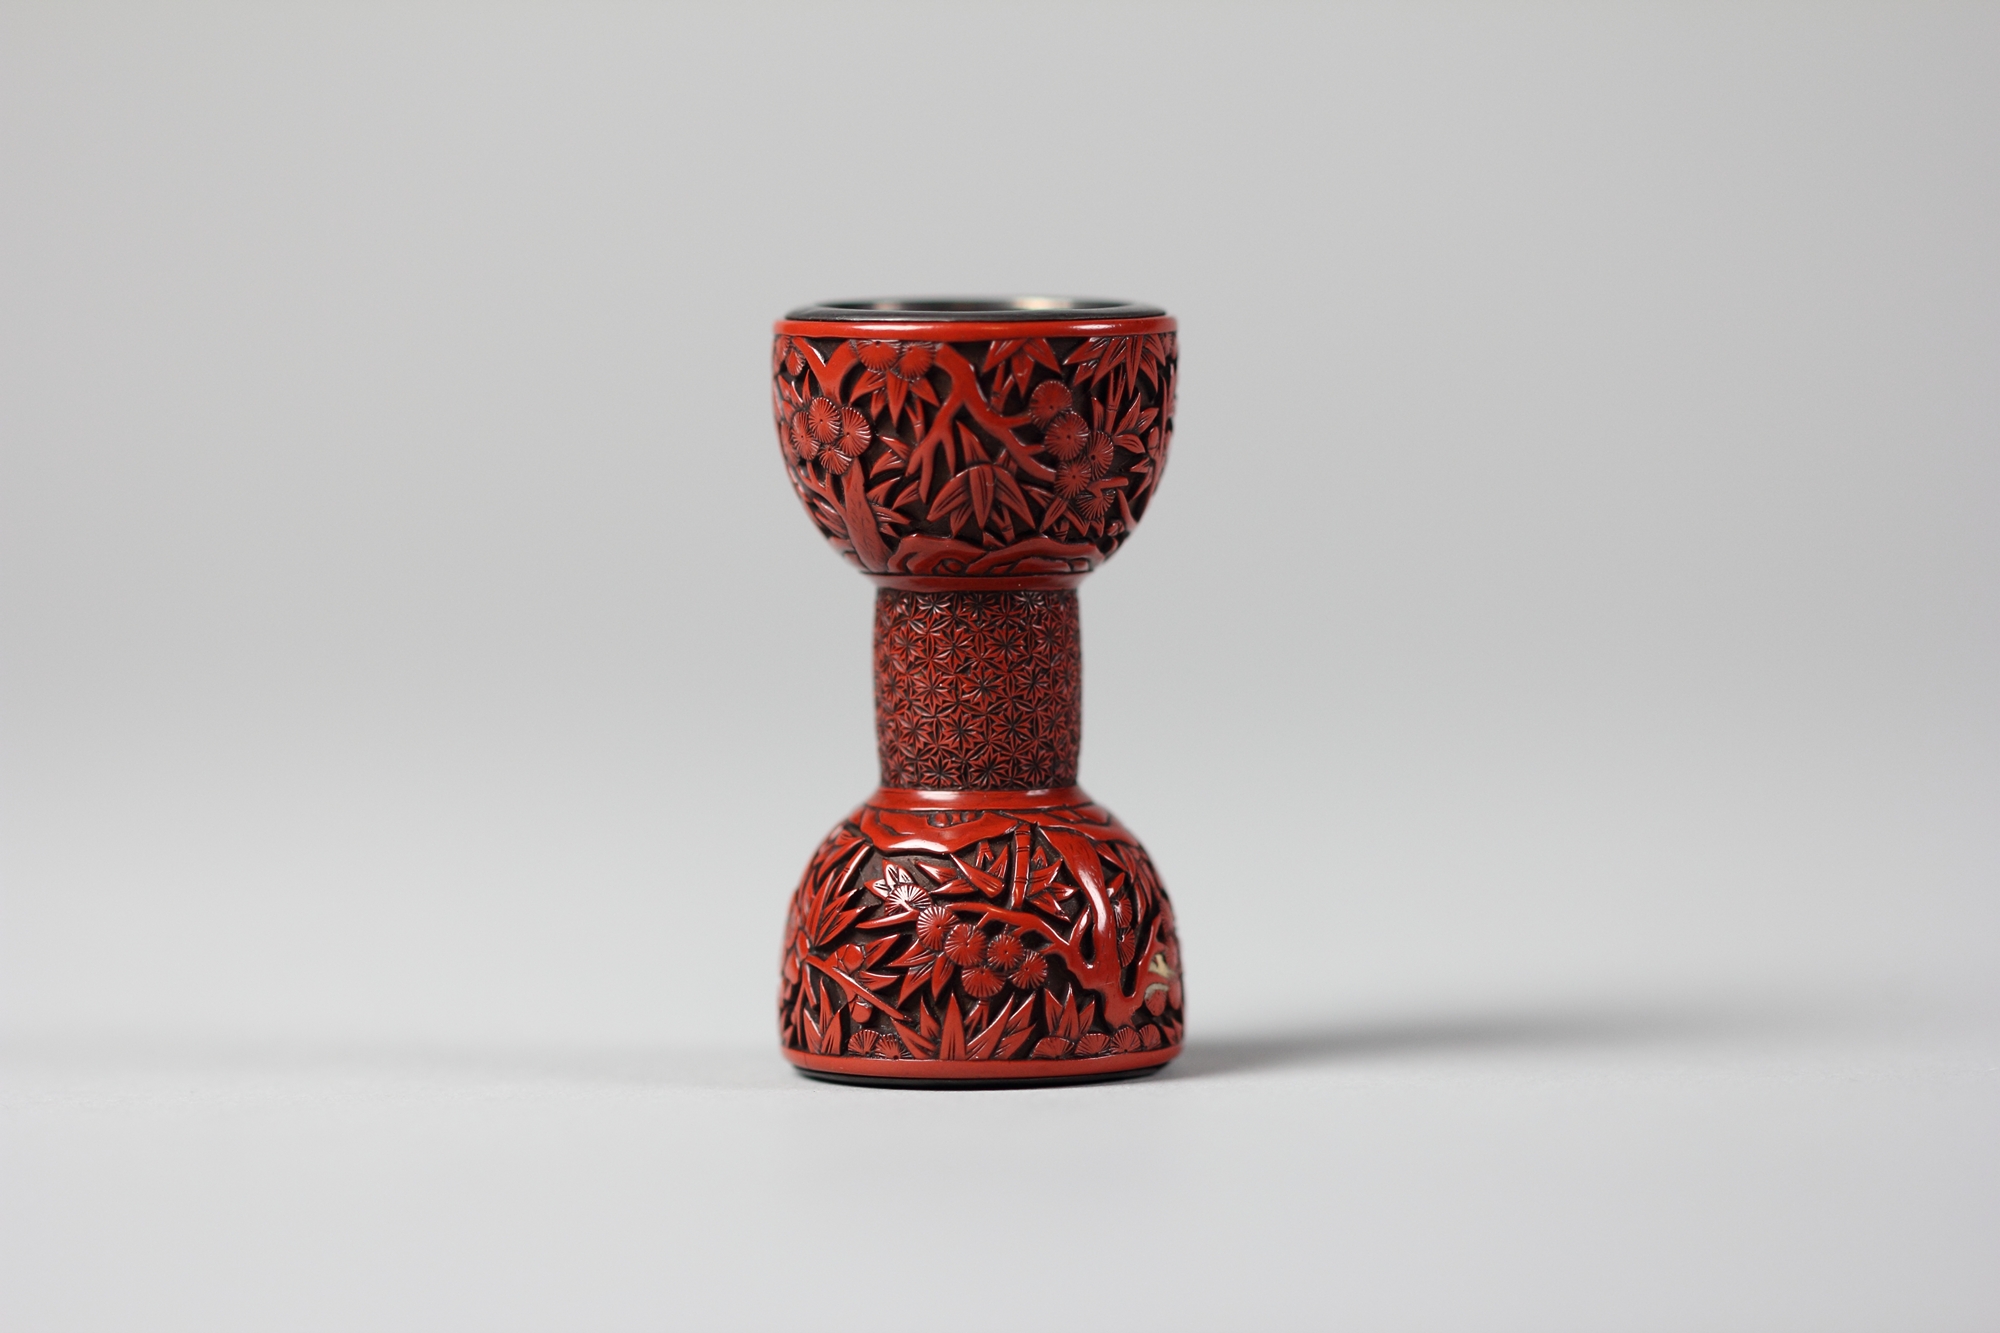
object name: netsuke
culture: japanese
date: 1801-1900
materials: lacquer